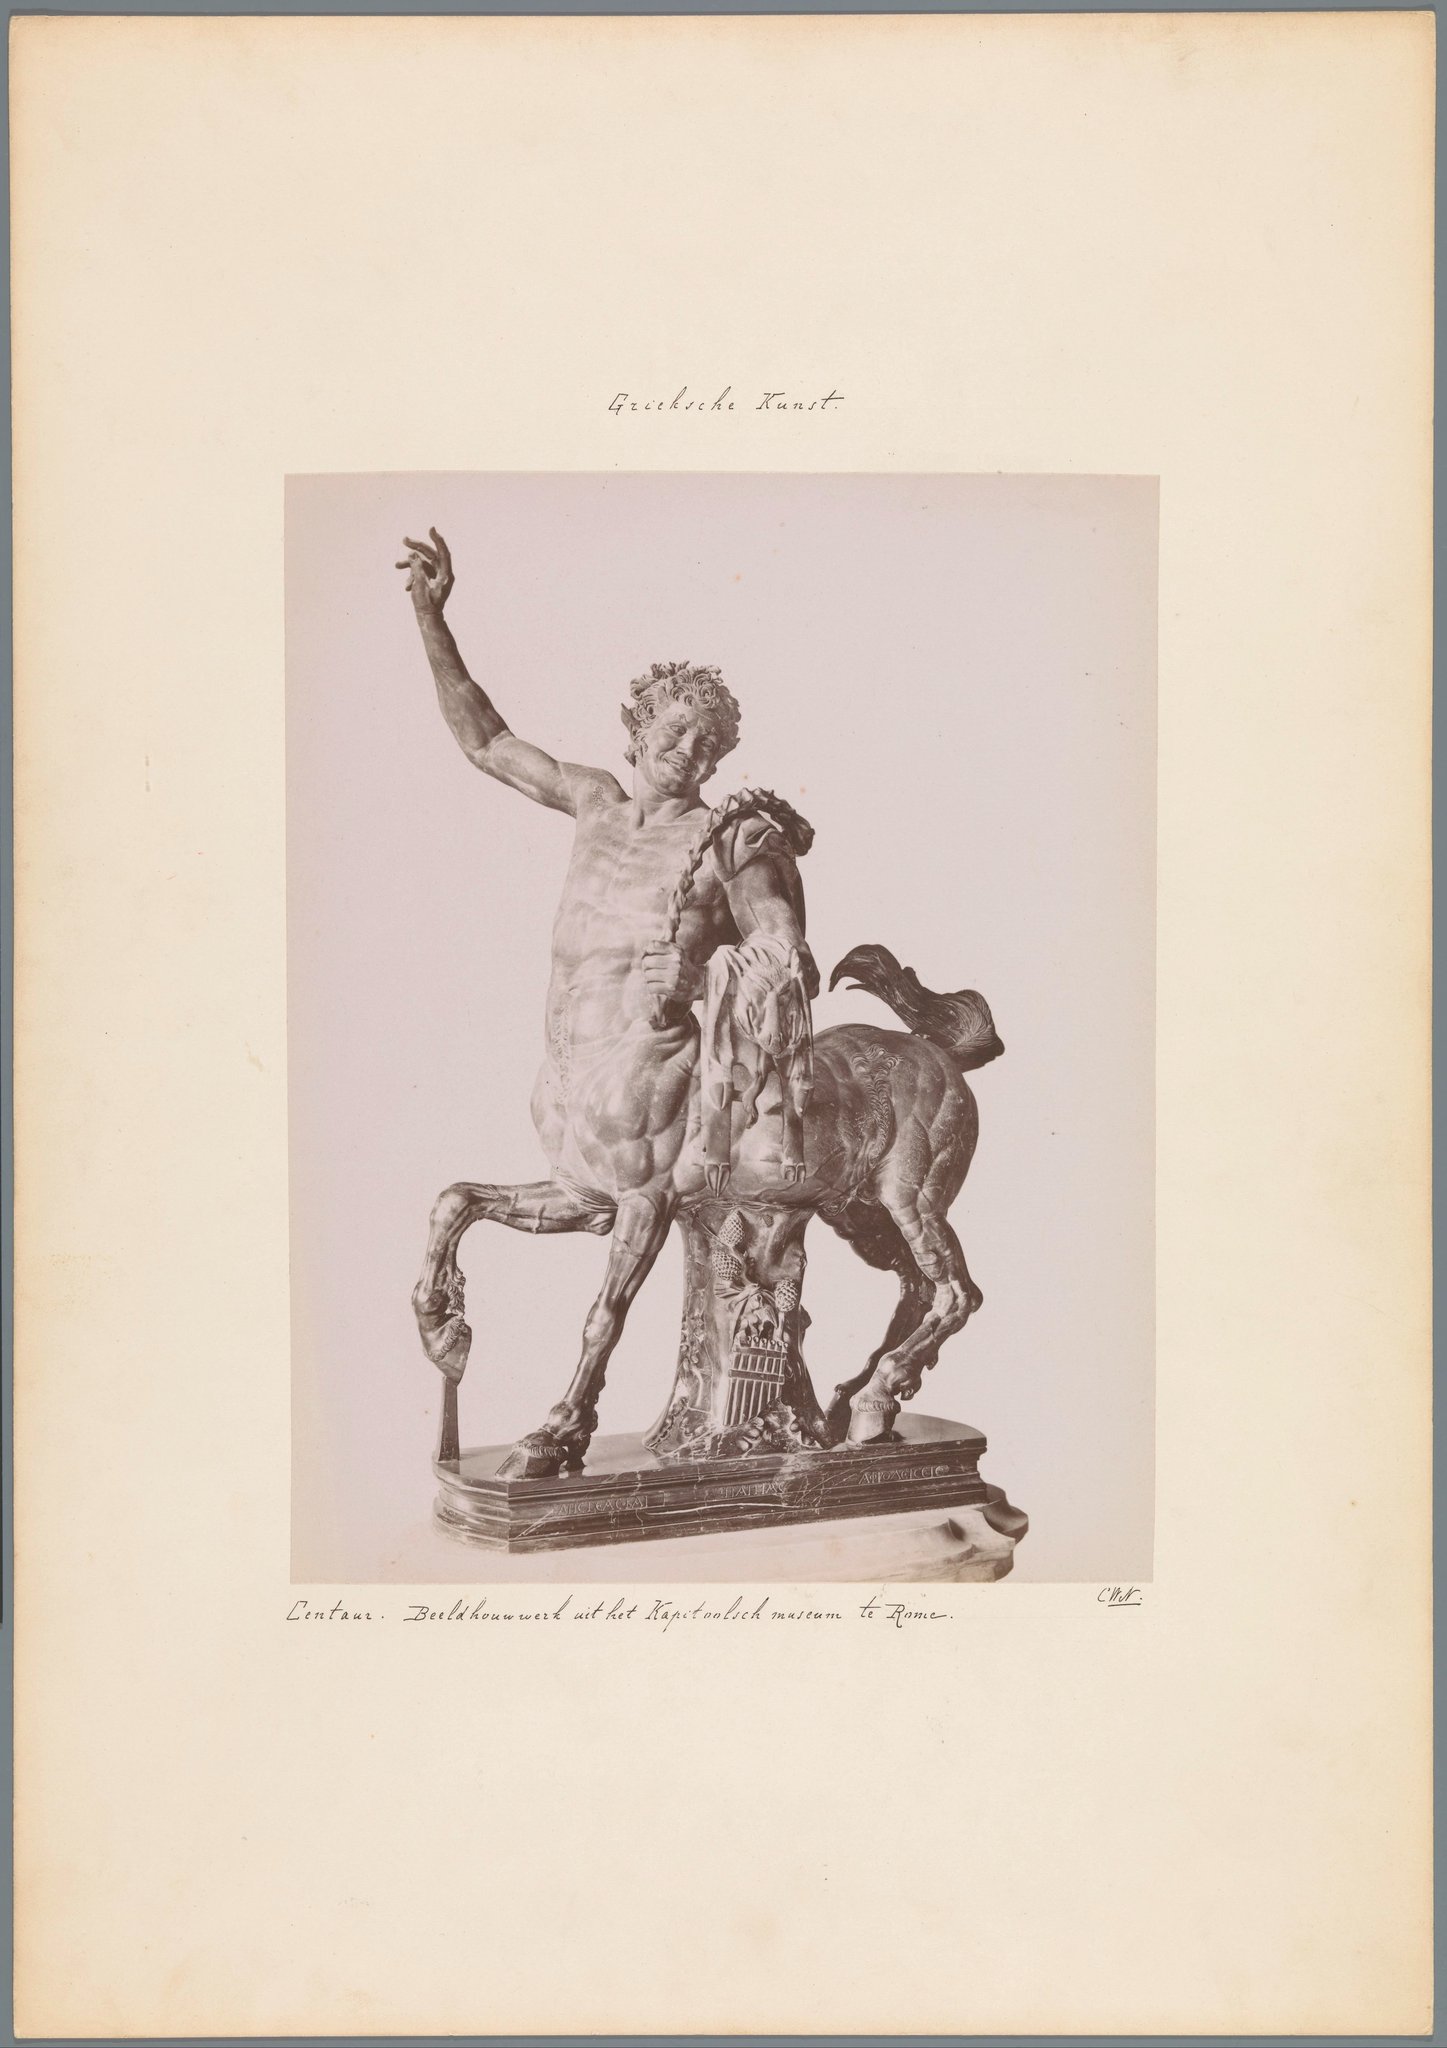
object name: photograph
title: Beeld van een centaur in de Capitolijnse Musea te Rome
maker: Anonymous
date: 1875-1900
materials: cardboard, photographic support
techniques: albumen print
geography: capitolijnse musea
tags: centaurs, sculpture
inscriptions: collector's mark: ‘KUNSTNIJVERHEIDSCHOOL QUELLINUS AMSTERDAM FRANS HALSSTRAAT 14.’, inscription: ‘CWN.’, collector's mark: ‘INSTITUUT VOOR KUNST- NIJVERHEIDSONDERWIJS GABRIËL METSUSTRAAT No. 16. AMSTERDAM’, inscription: ‘Grieksche Kunst. Centaur. Beeldhouwwerk uit het Kapitoolsch museum te Rome.’